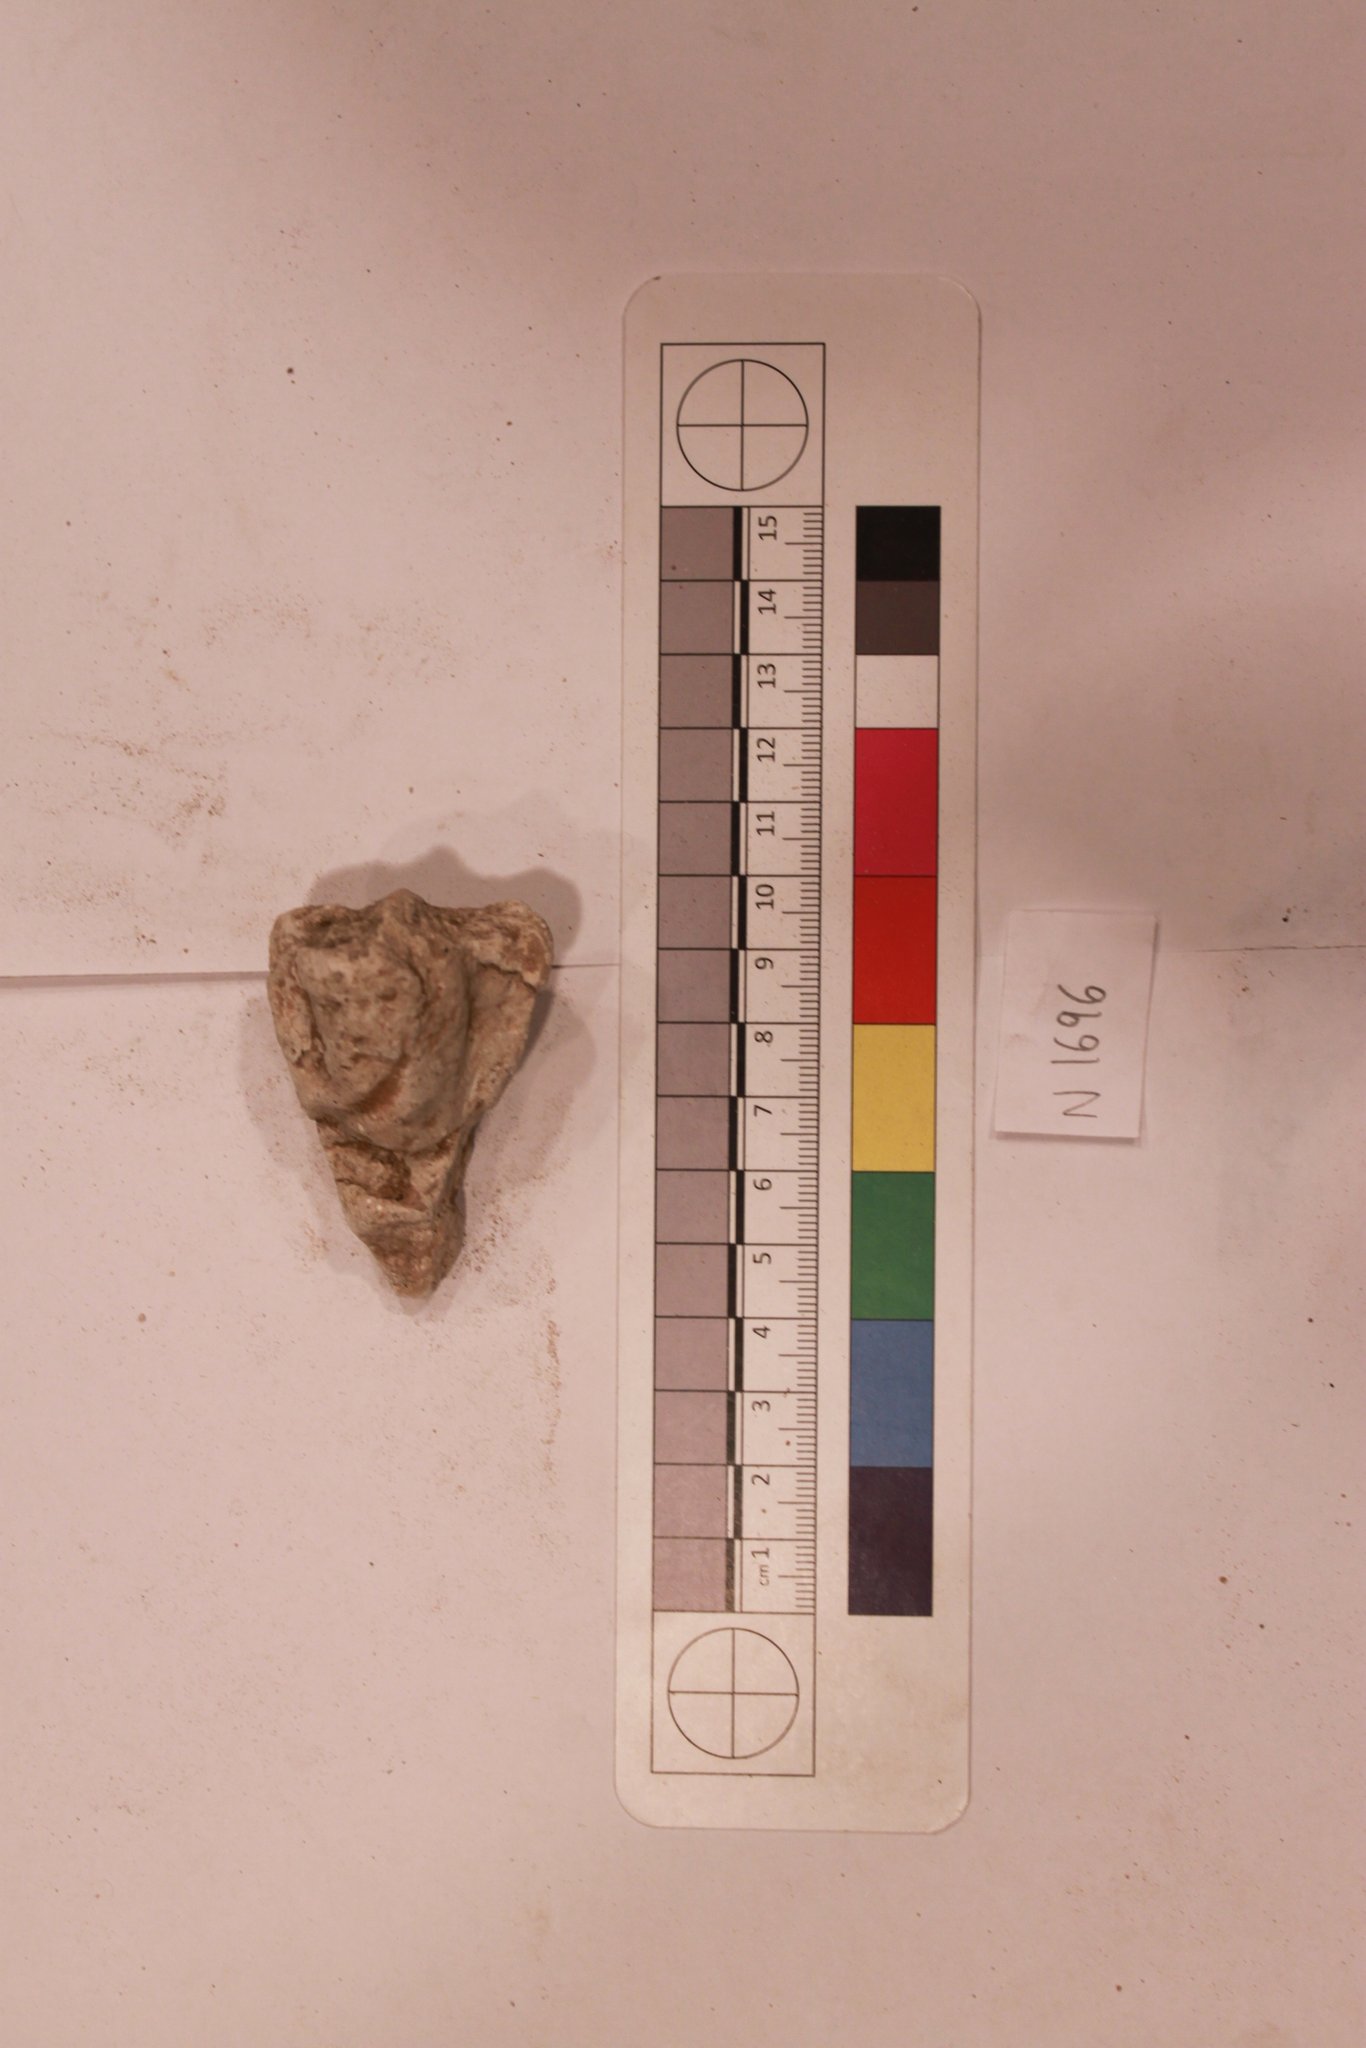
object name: fragment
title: Stucco Fragment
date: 701-1200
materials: plaster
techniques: carving, painting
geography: iran